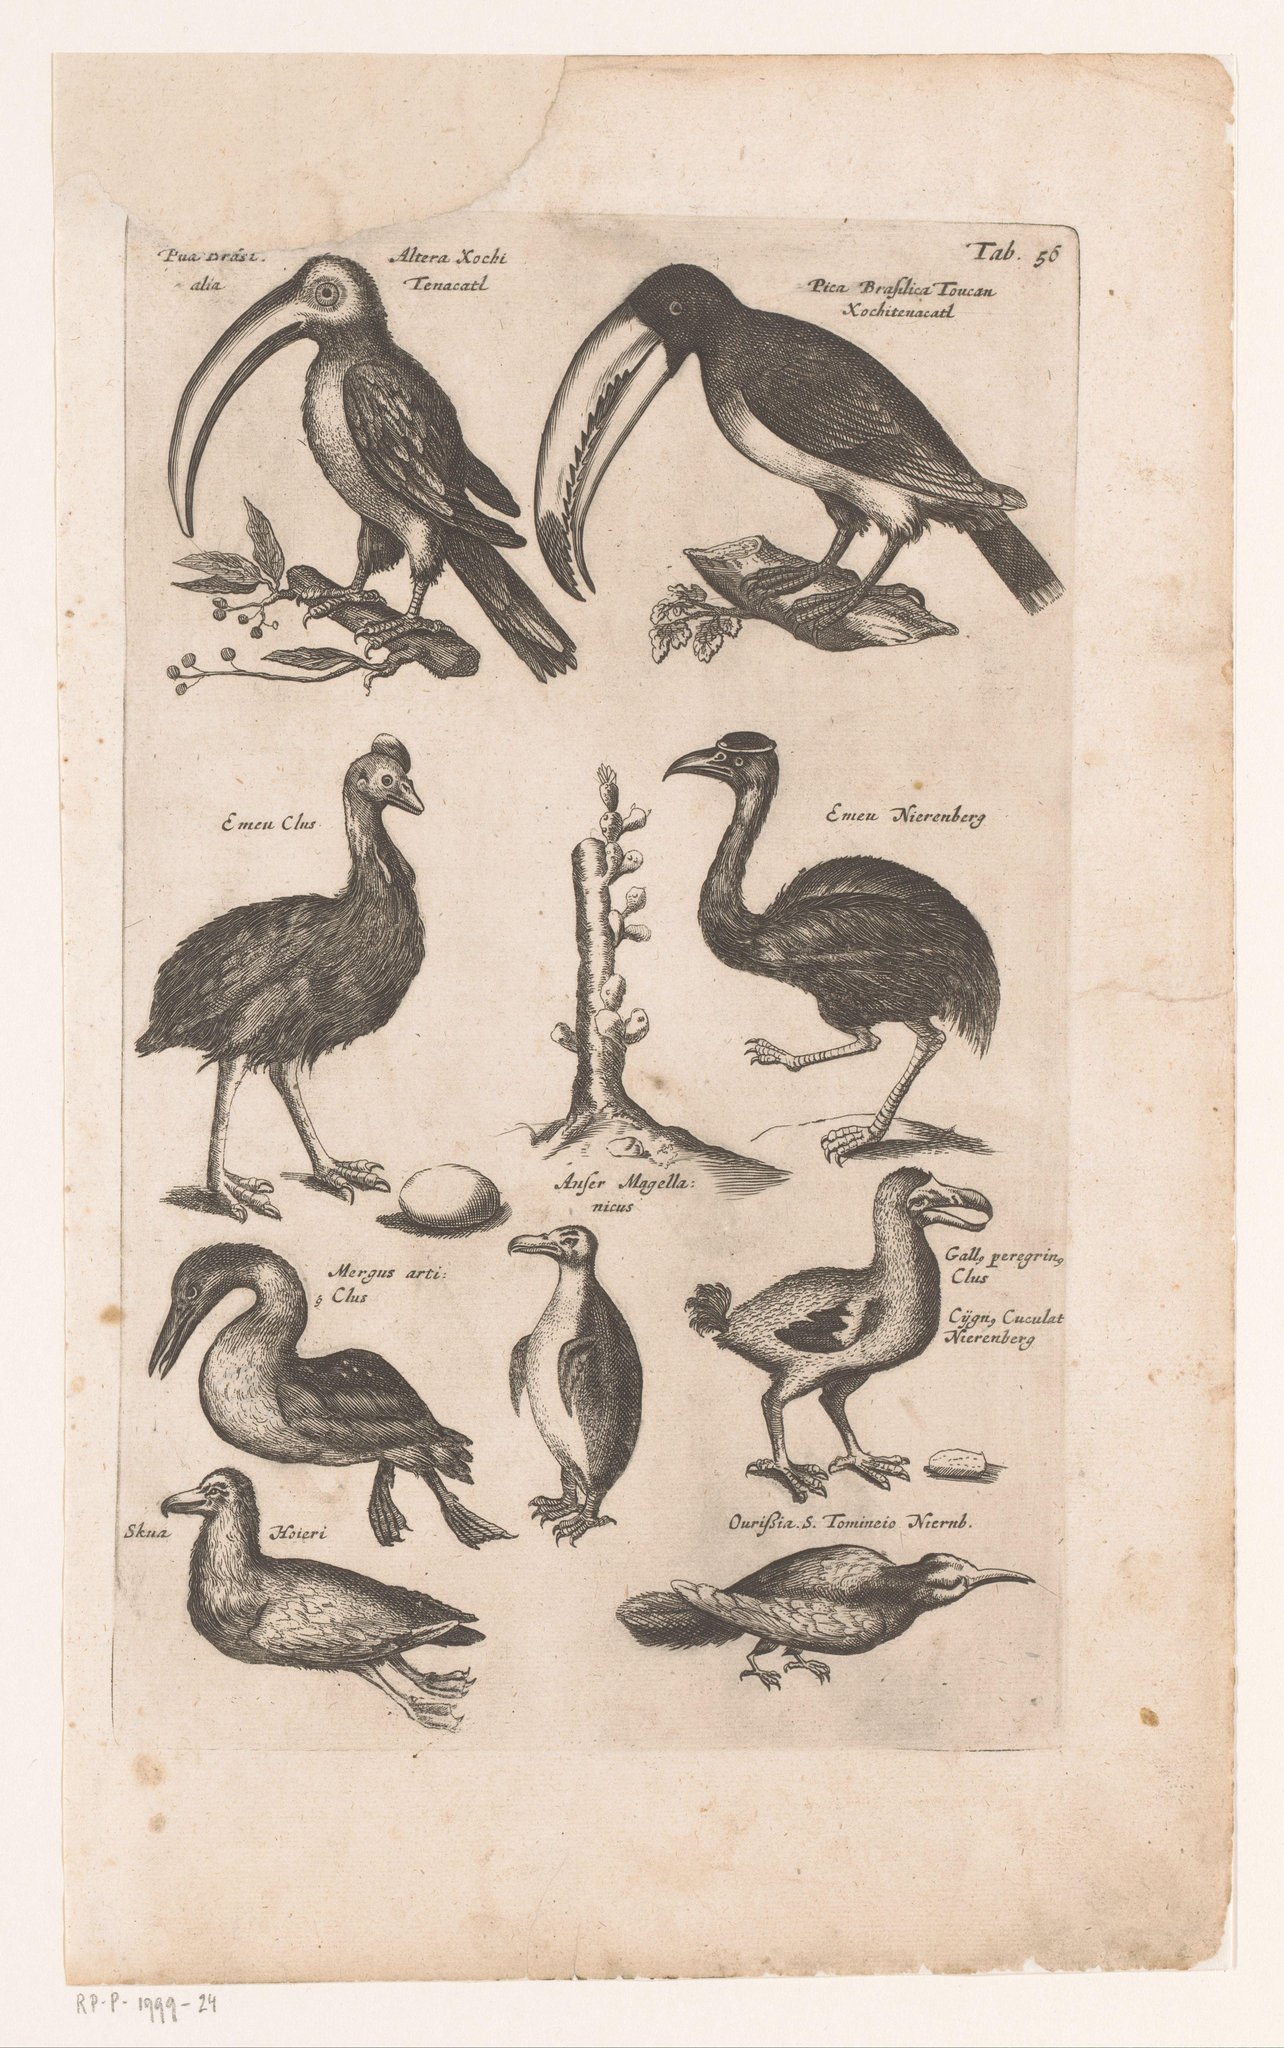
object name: book illustration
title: Historica naturalis de avibus, Libri VI J. Jonston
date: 1657-1667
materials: paper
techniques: etching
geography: germany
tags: other birds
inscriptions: collector's mark: Lugt 2228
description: Blad 56 uit: Johannes Jonstonus. Historiae naturalis de quadrupedibus libri, cum aenis figuris. Amsterdam, J.J. Schipper, 1657.